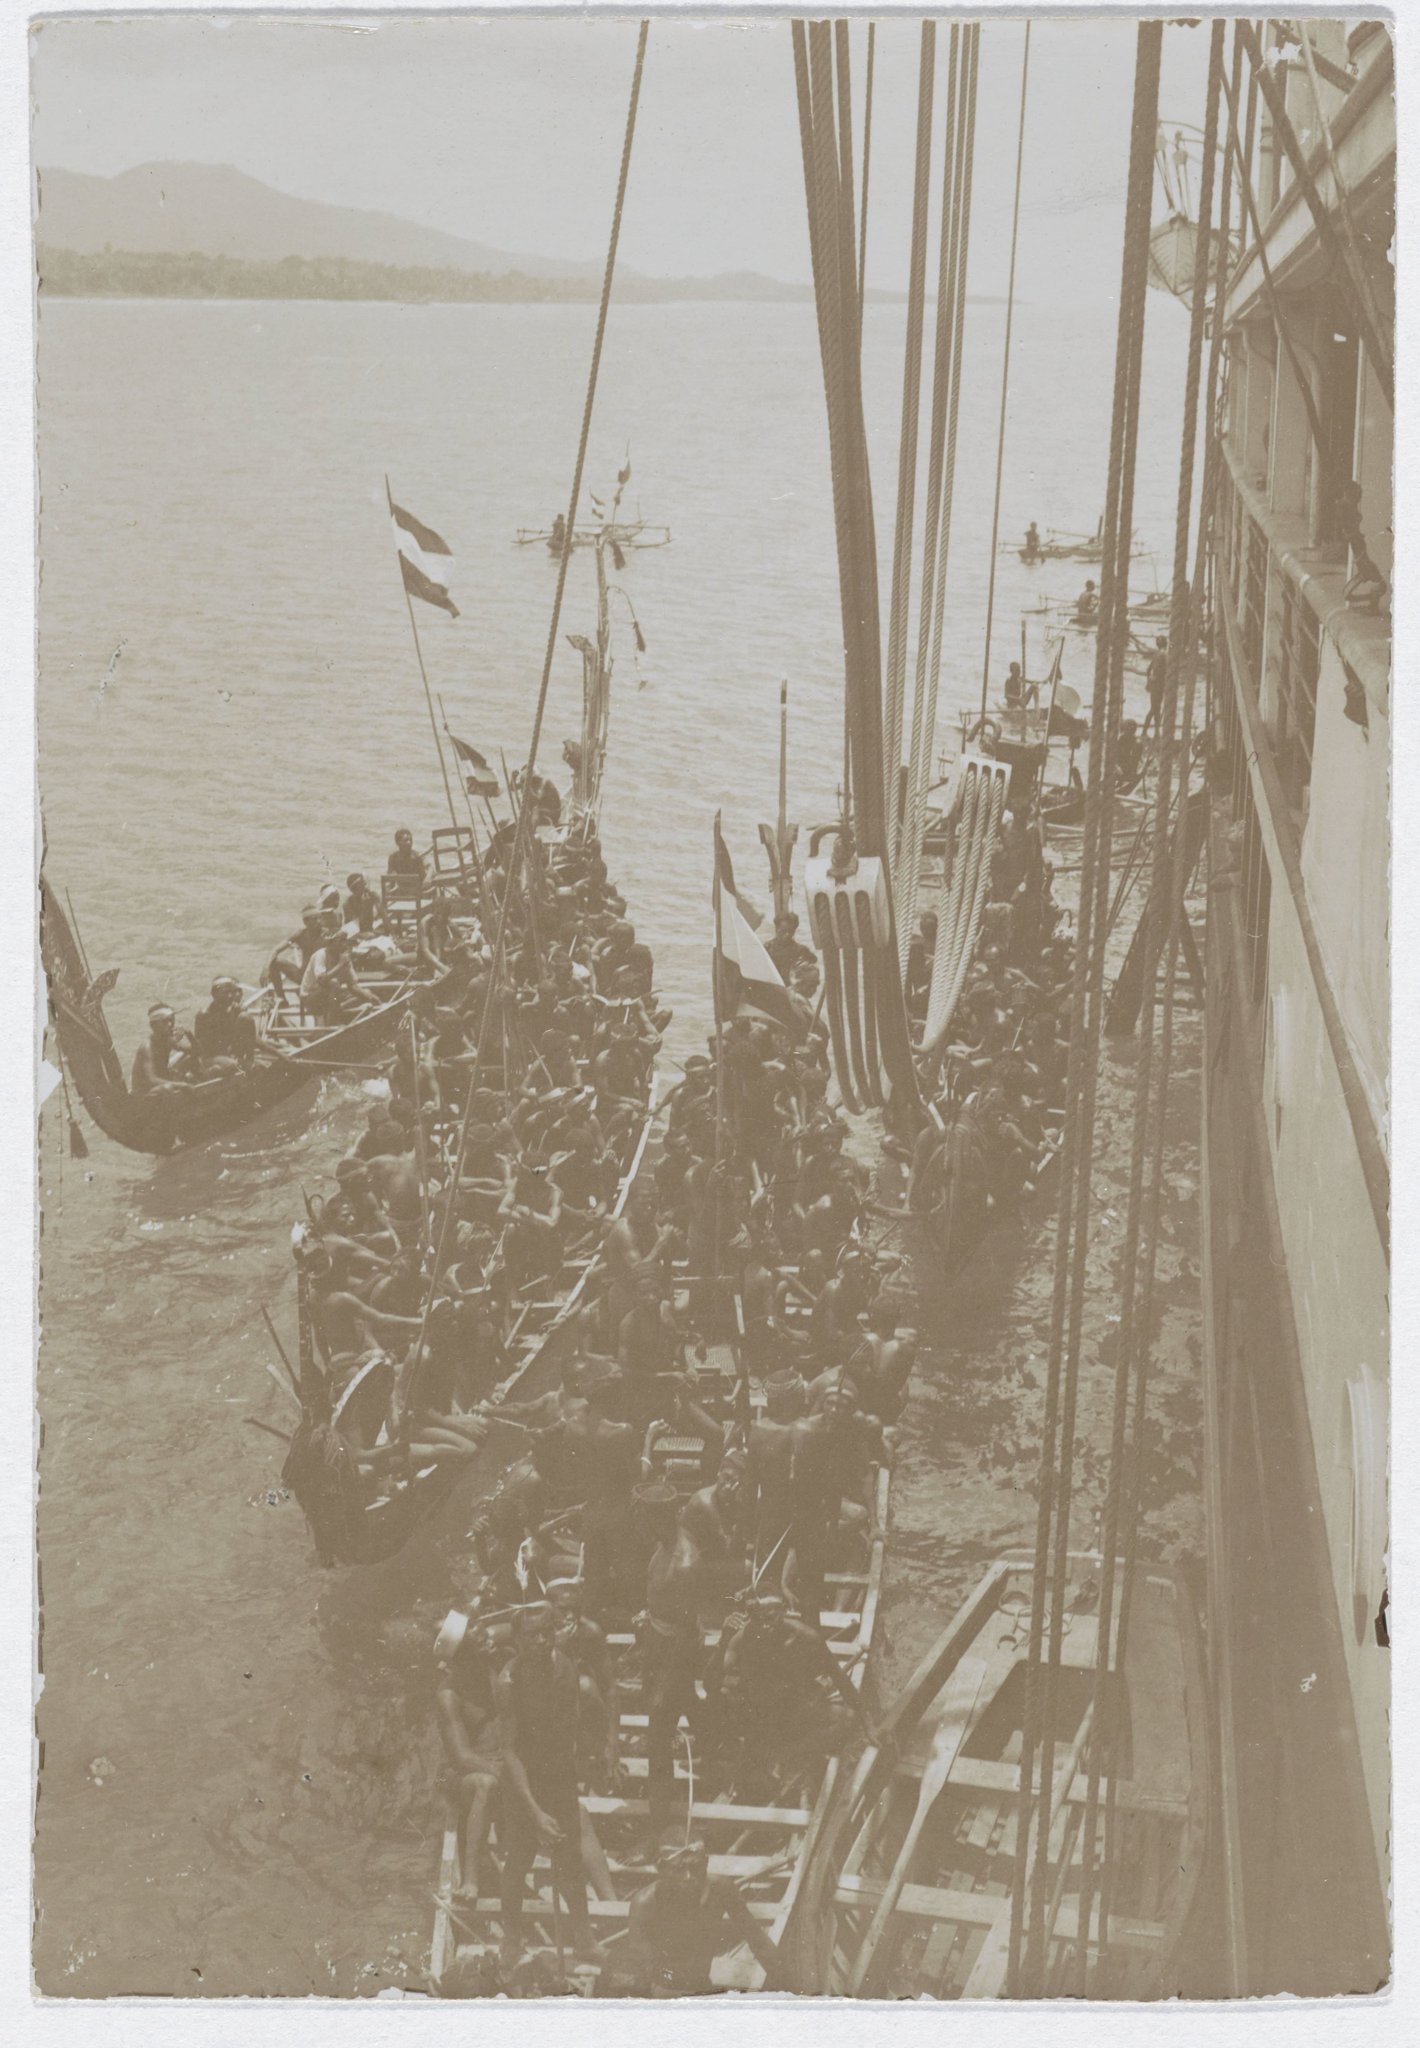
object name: photograph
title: Roeiboten met lokale bewoners langs zij van een aangemeerde grote stoomboot.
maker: johanna hermina marmelstein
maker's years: 1897-1990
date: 1900-1915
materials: paper, photographic support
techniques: albumen print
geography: jakarta